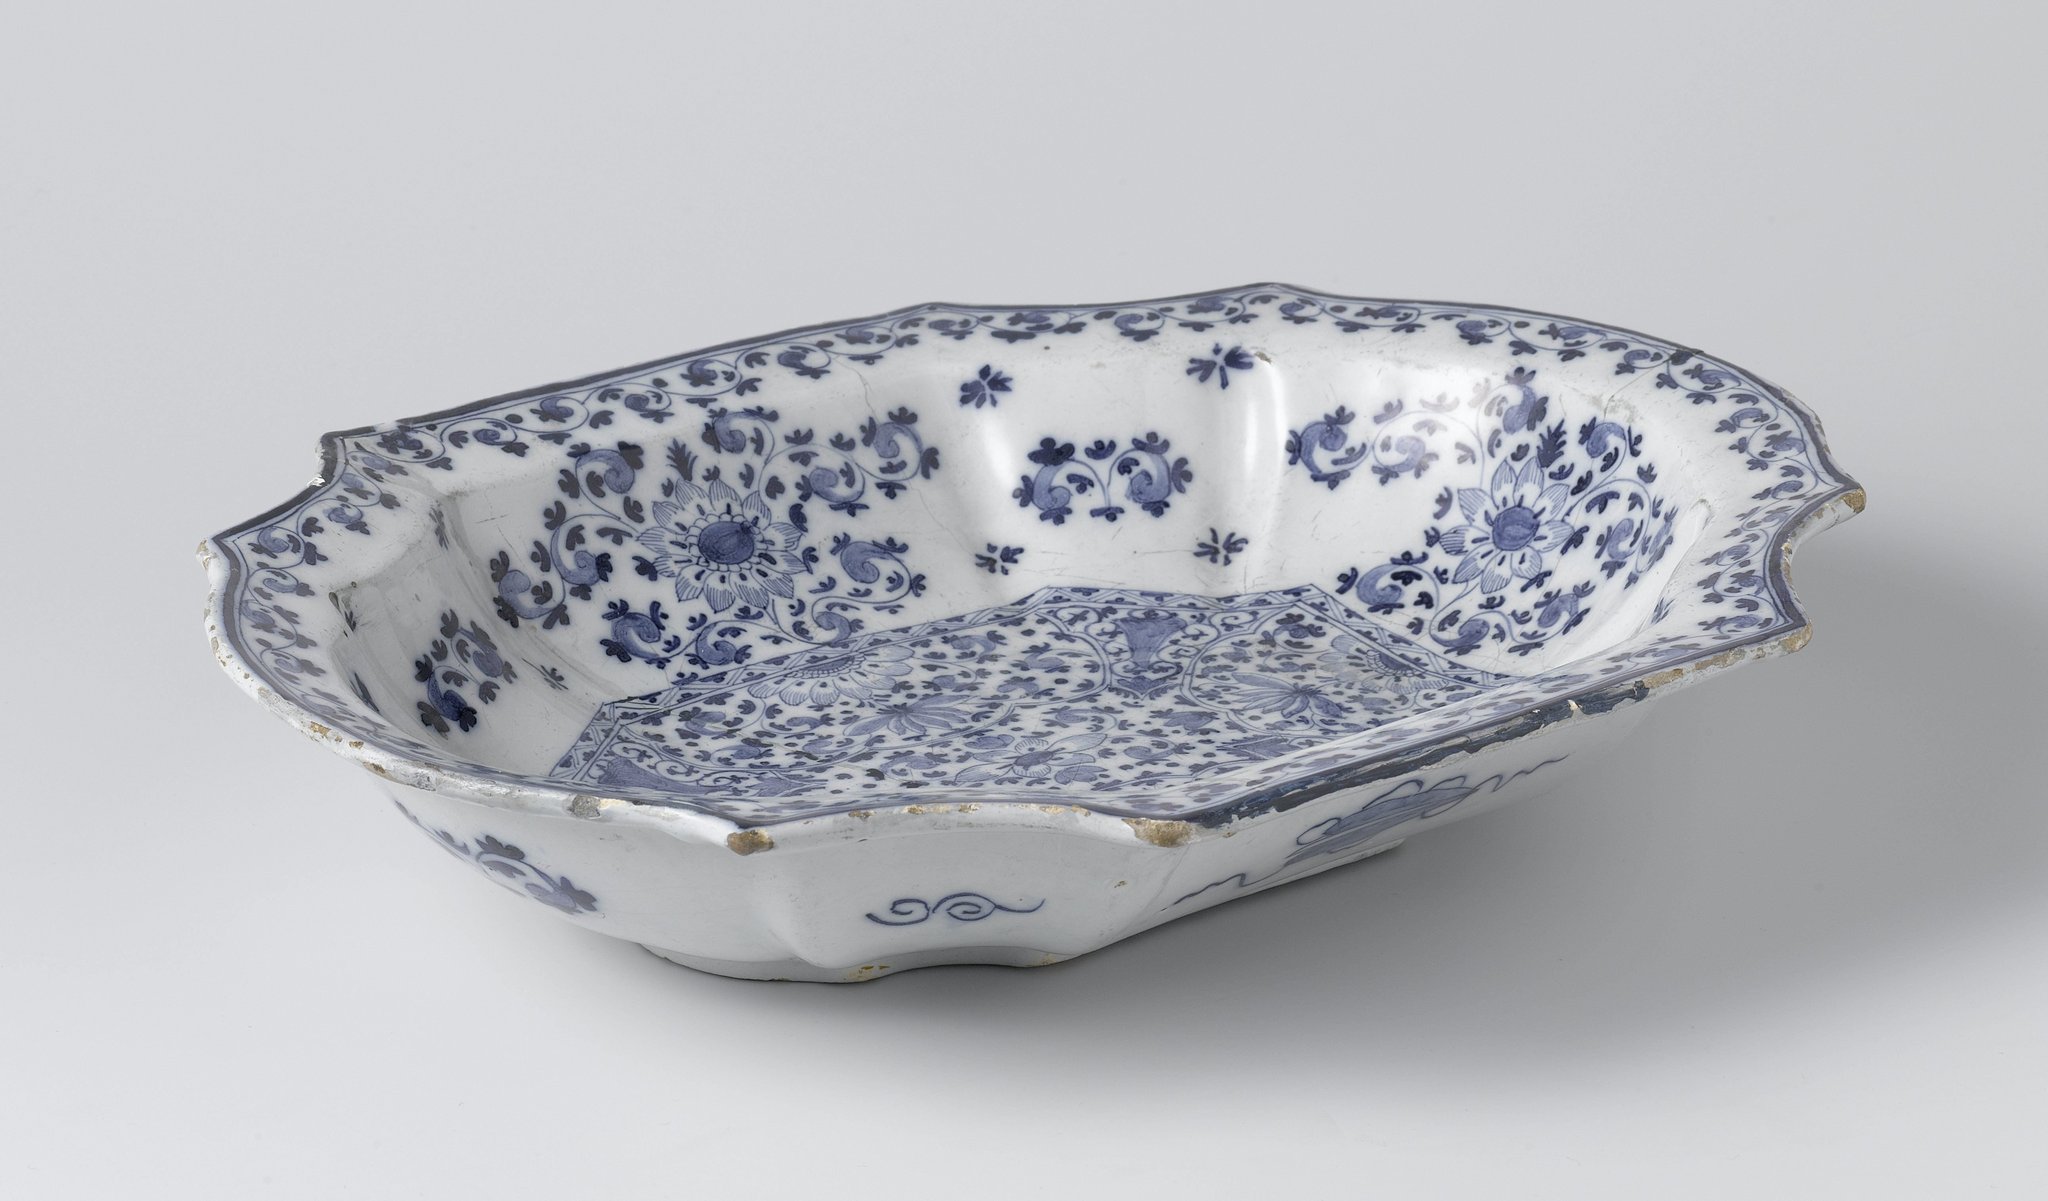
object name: salad bowl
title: Slabak van blauw beschilderde faience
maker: hugo brouwer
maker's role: eigenaar plateelbakkerij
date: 1750-1775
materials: faience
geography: delft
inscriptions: mark: ‘HB(ineen)/ 160’